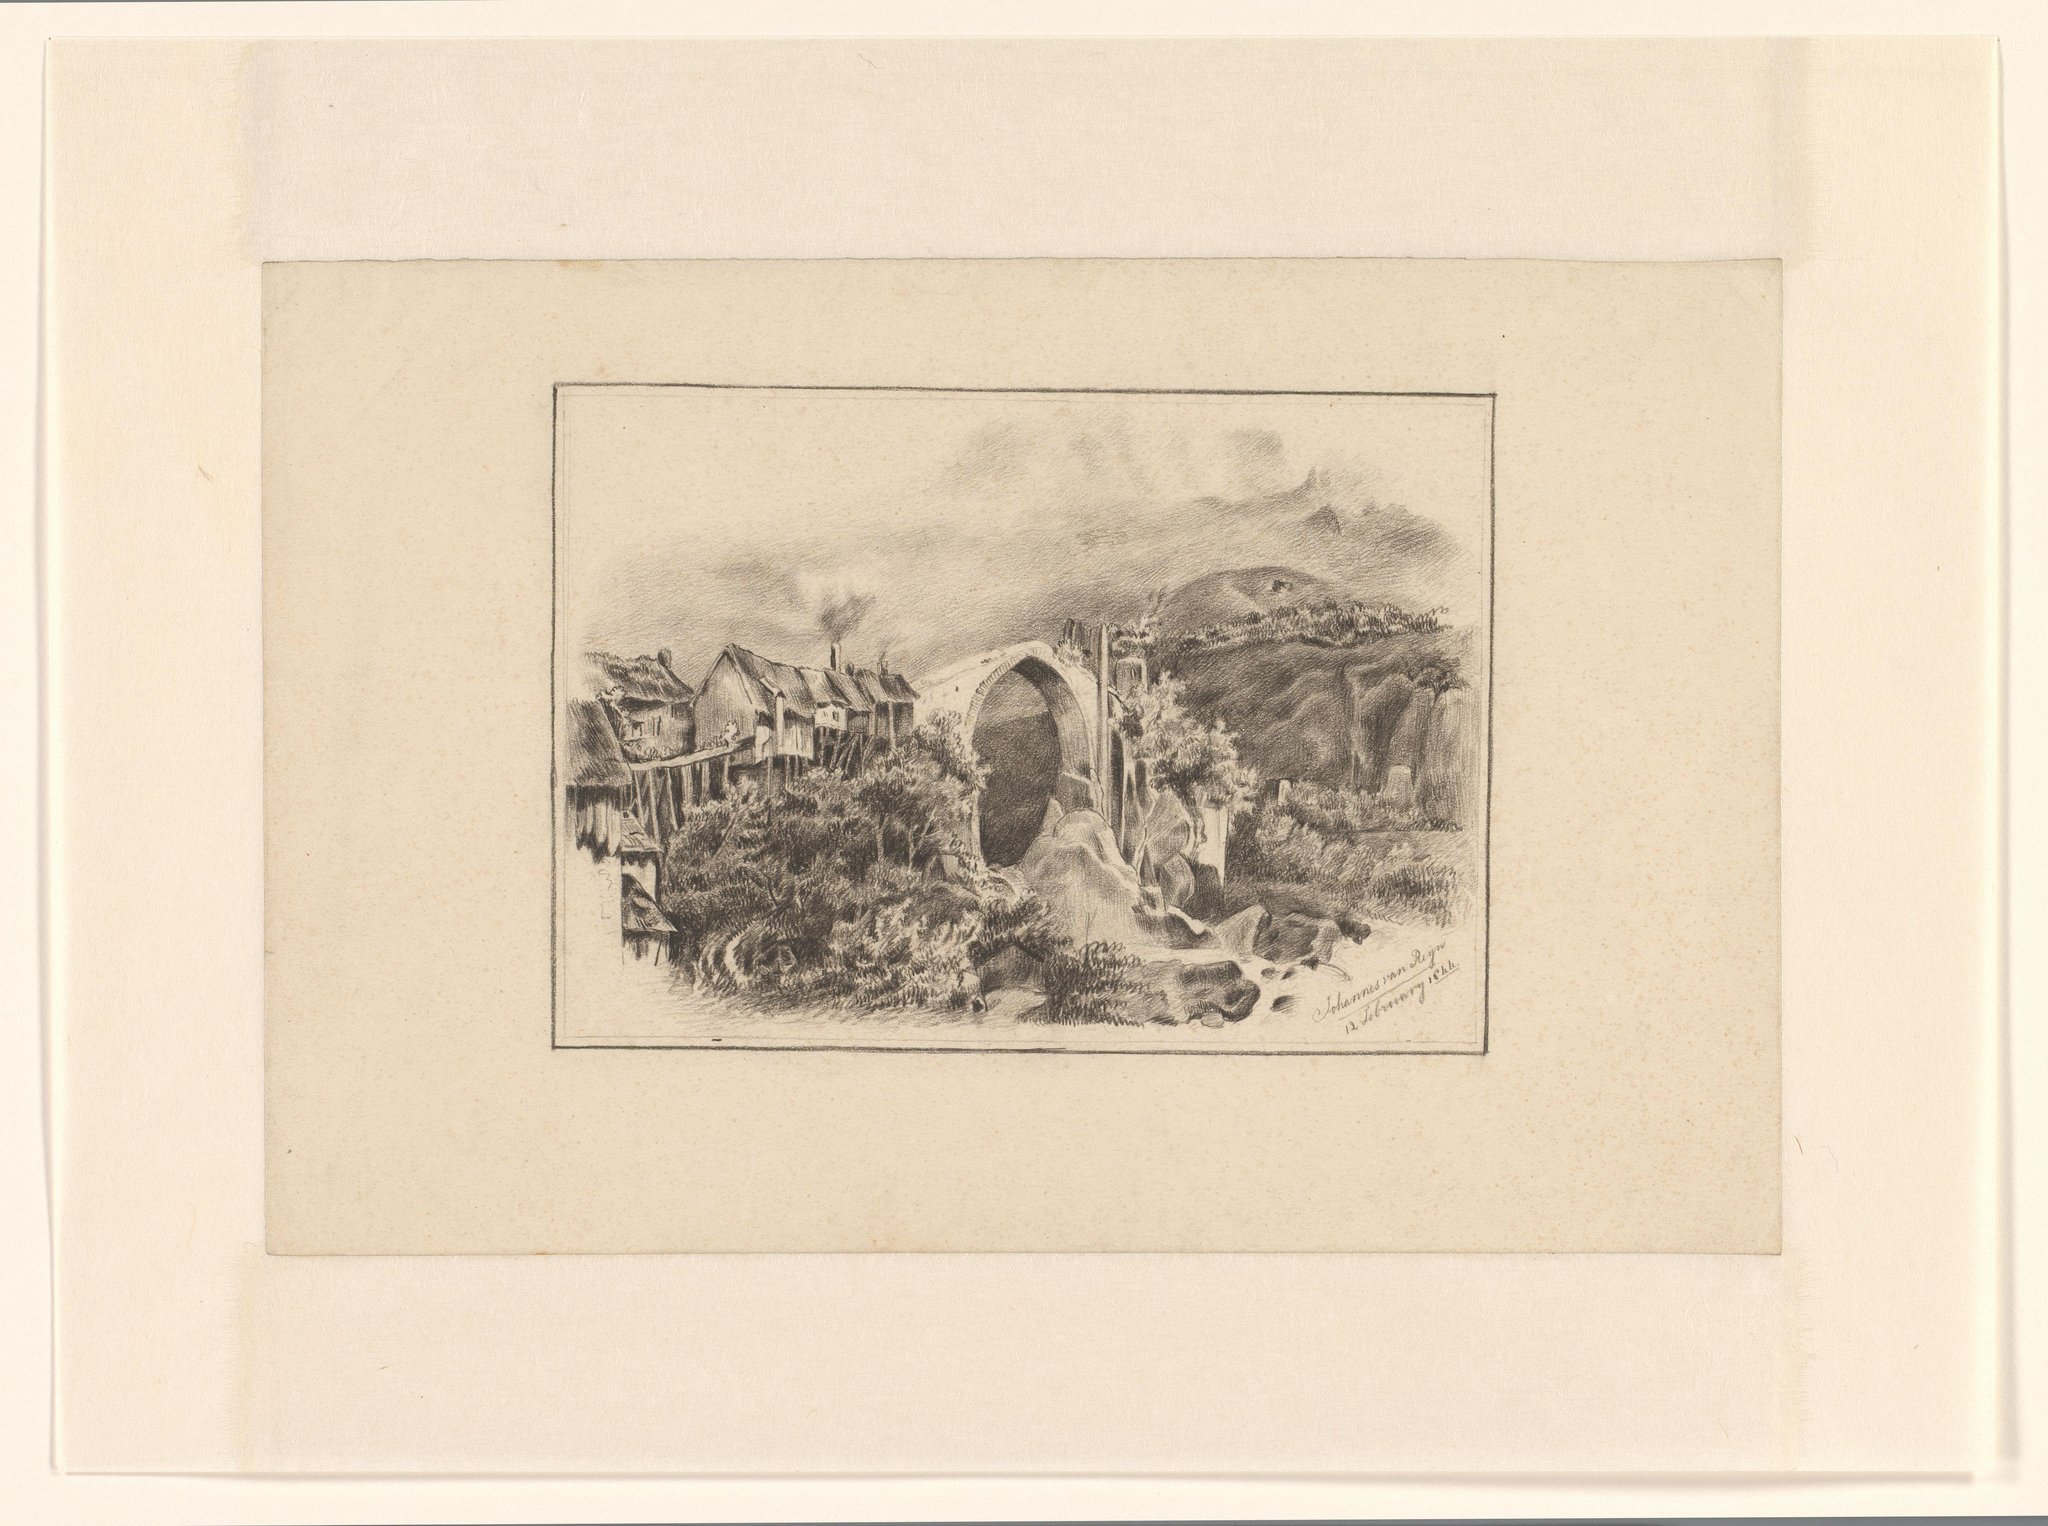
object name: drawing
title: Berglandschap met stenen brug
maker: johannes van reijn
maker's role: draughtsman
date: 1844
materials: chalk, paper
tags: landscape with bridge, viaduct or aqueduct, mountains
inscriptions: signature and date: ‘Johannes van Reijn/ 12 February 1844.’